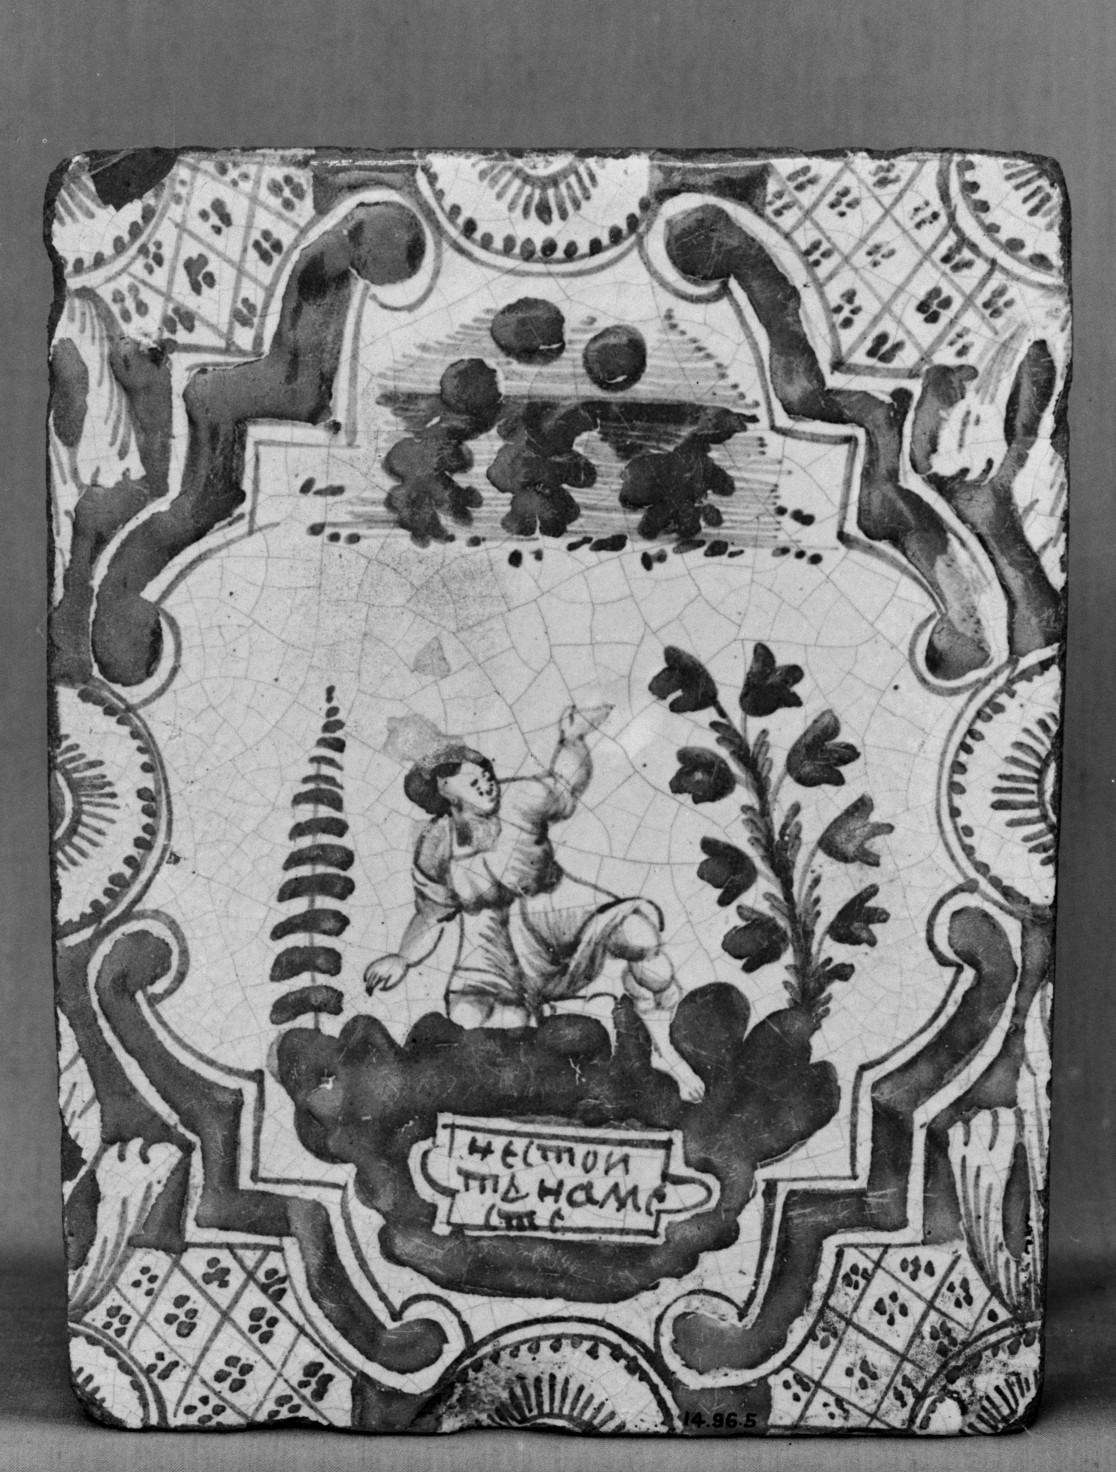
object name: stove tile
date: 1701-1800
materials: pottery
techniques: glazing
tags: human figures,plants